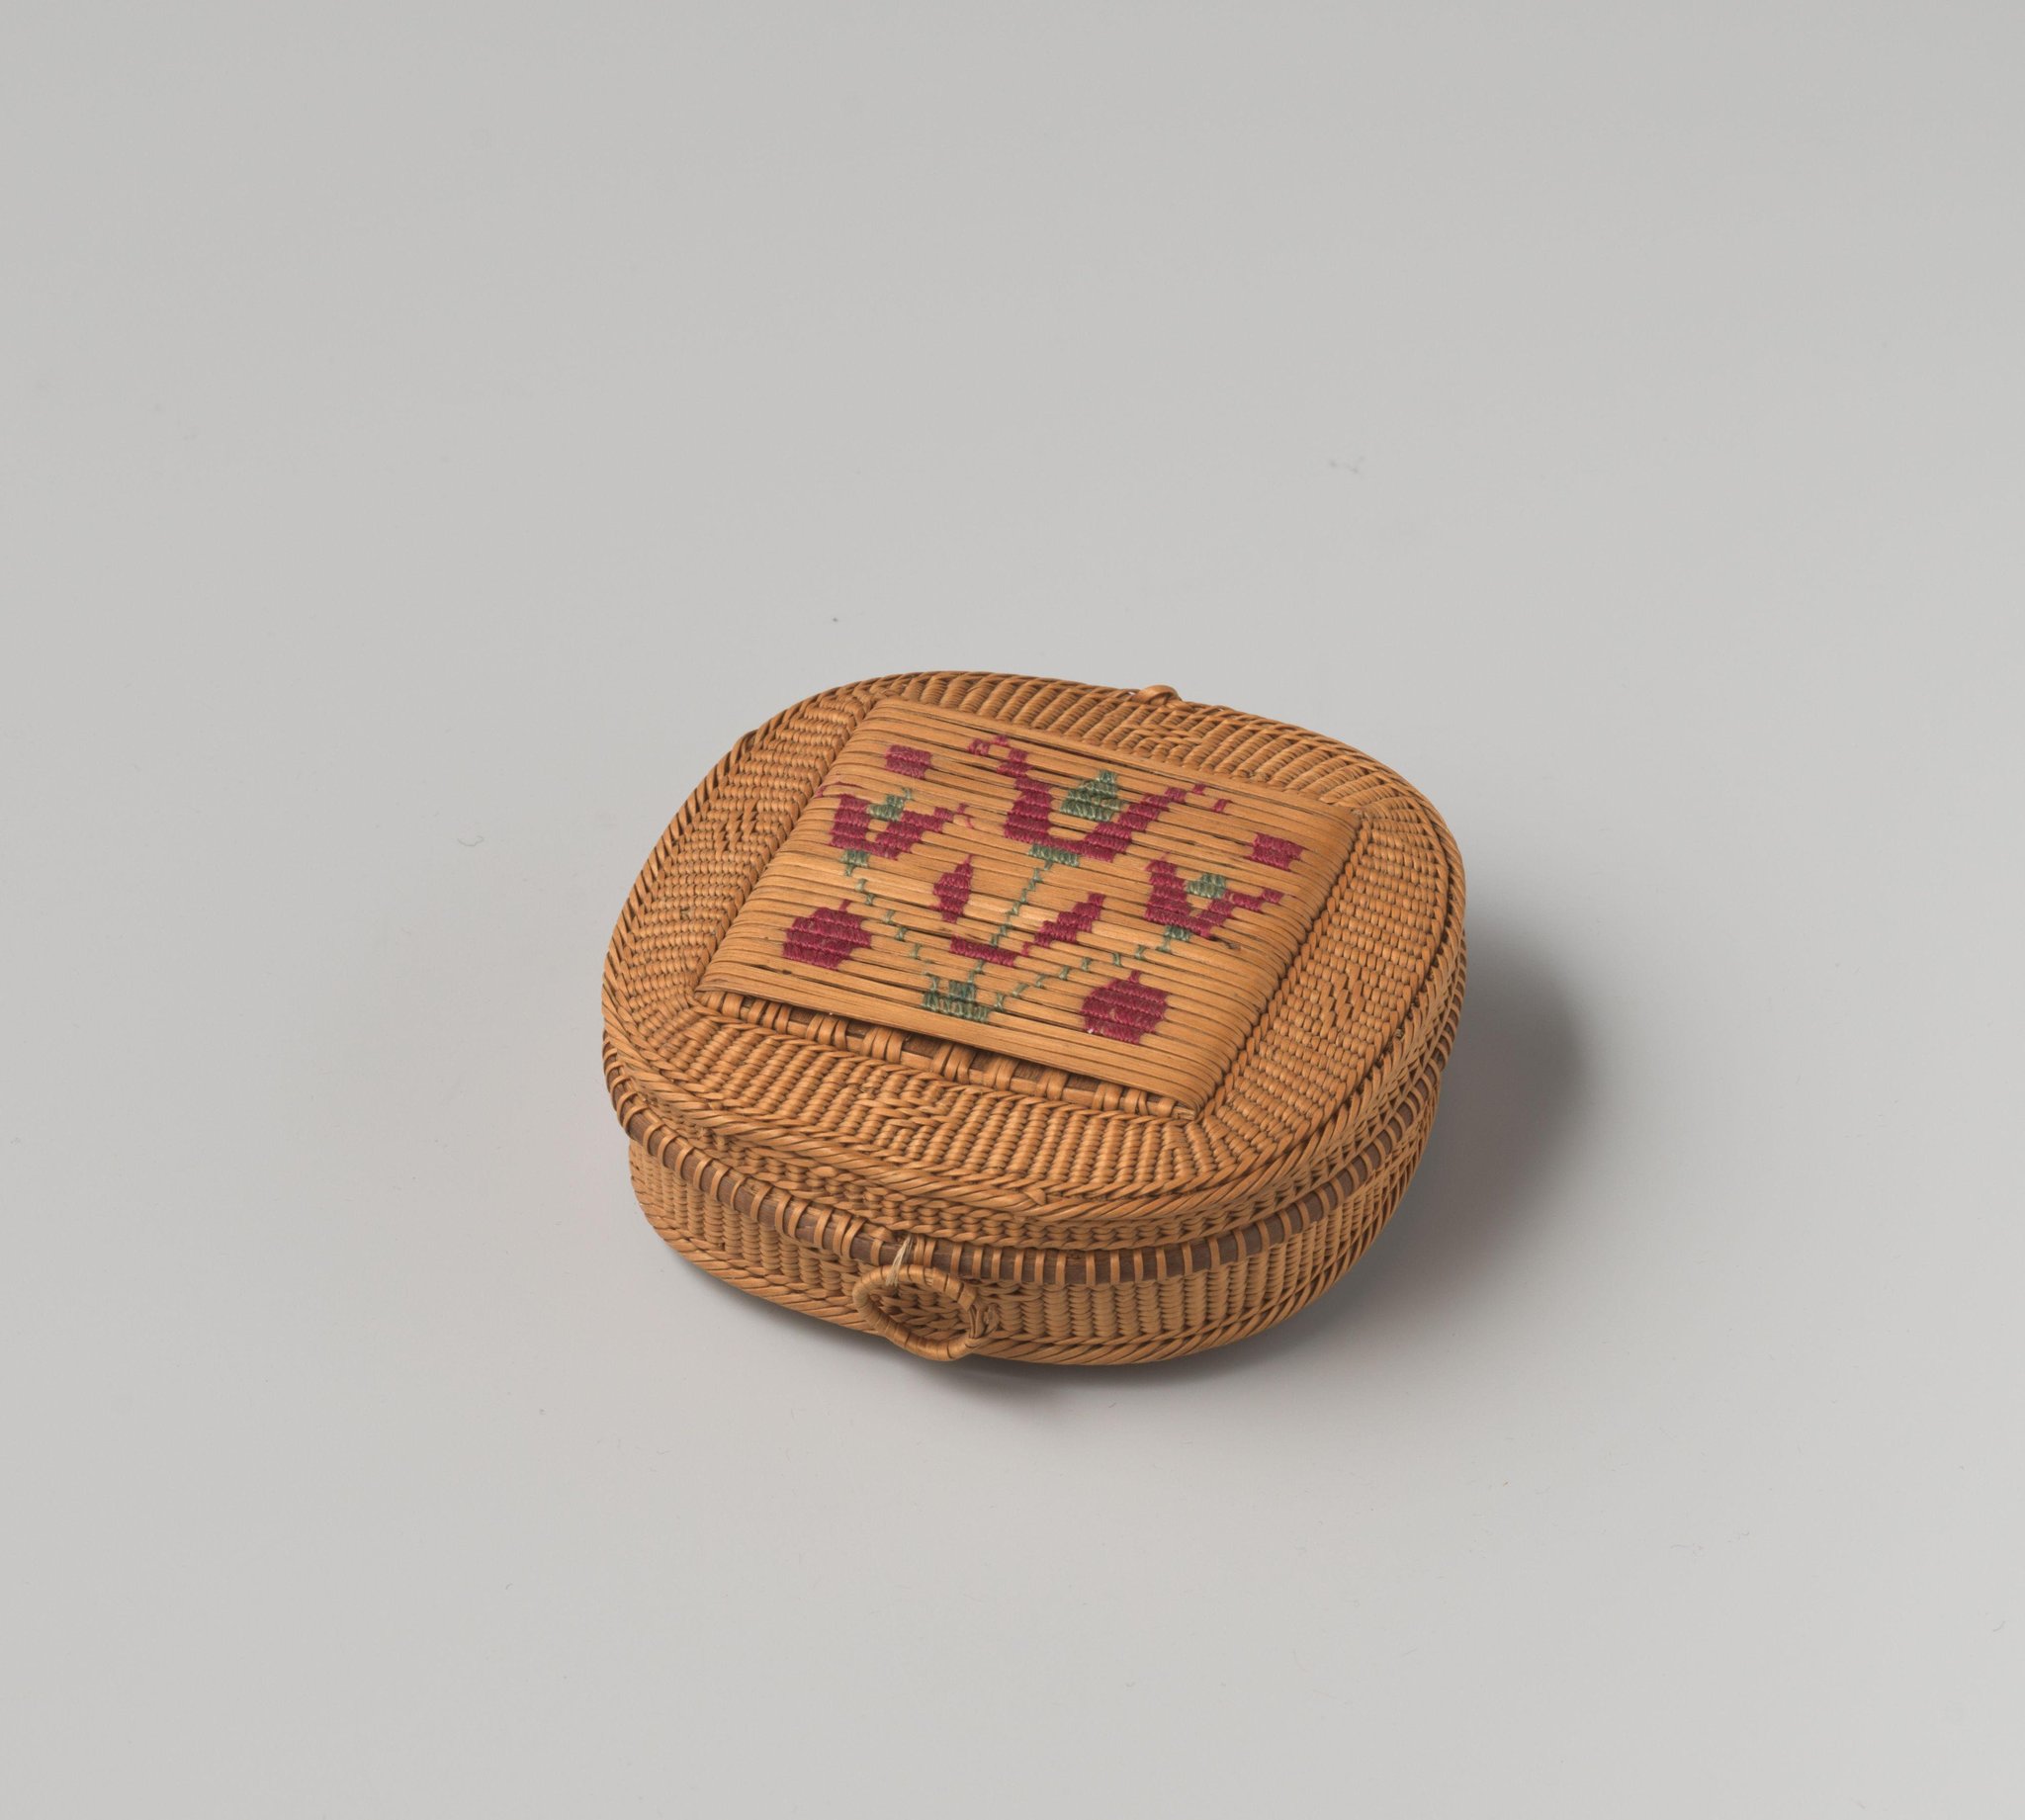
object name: luiermand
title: Platte vierkant / ronde mand van gespleten wilgenteen (fijnscheenwerk), zeer fijn gevlochten met geometrisch ruitpatroon, deksel en bodem geborduurd met tulpmotief van zijde.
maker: Anonymous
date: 1675-1710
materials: plant material, silk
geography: halle